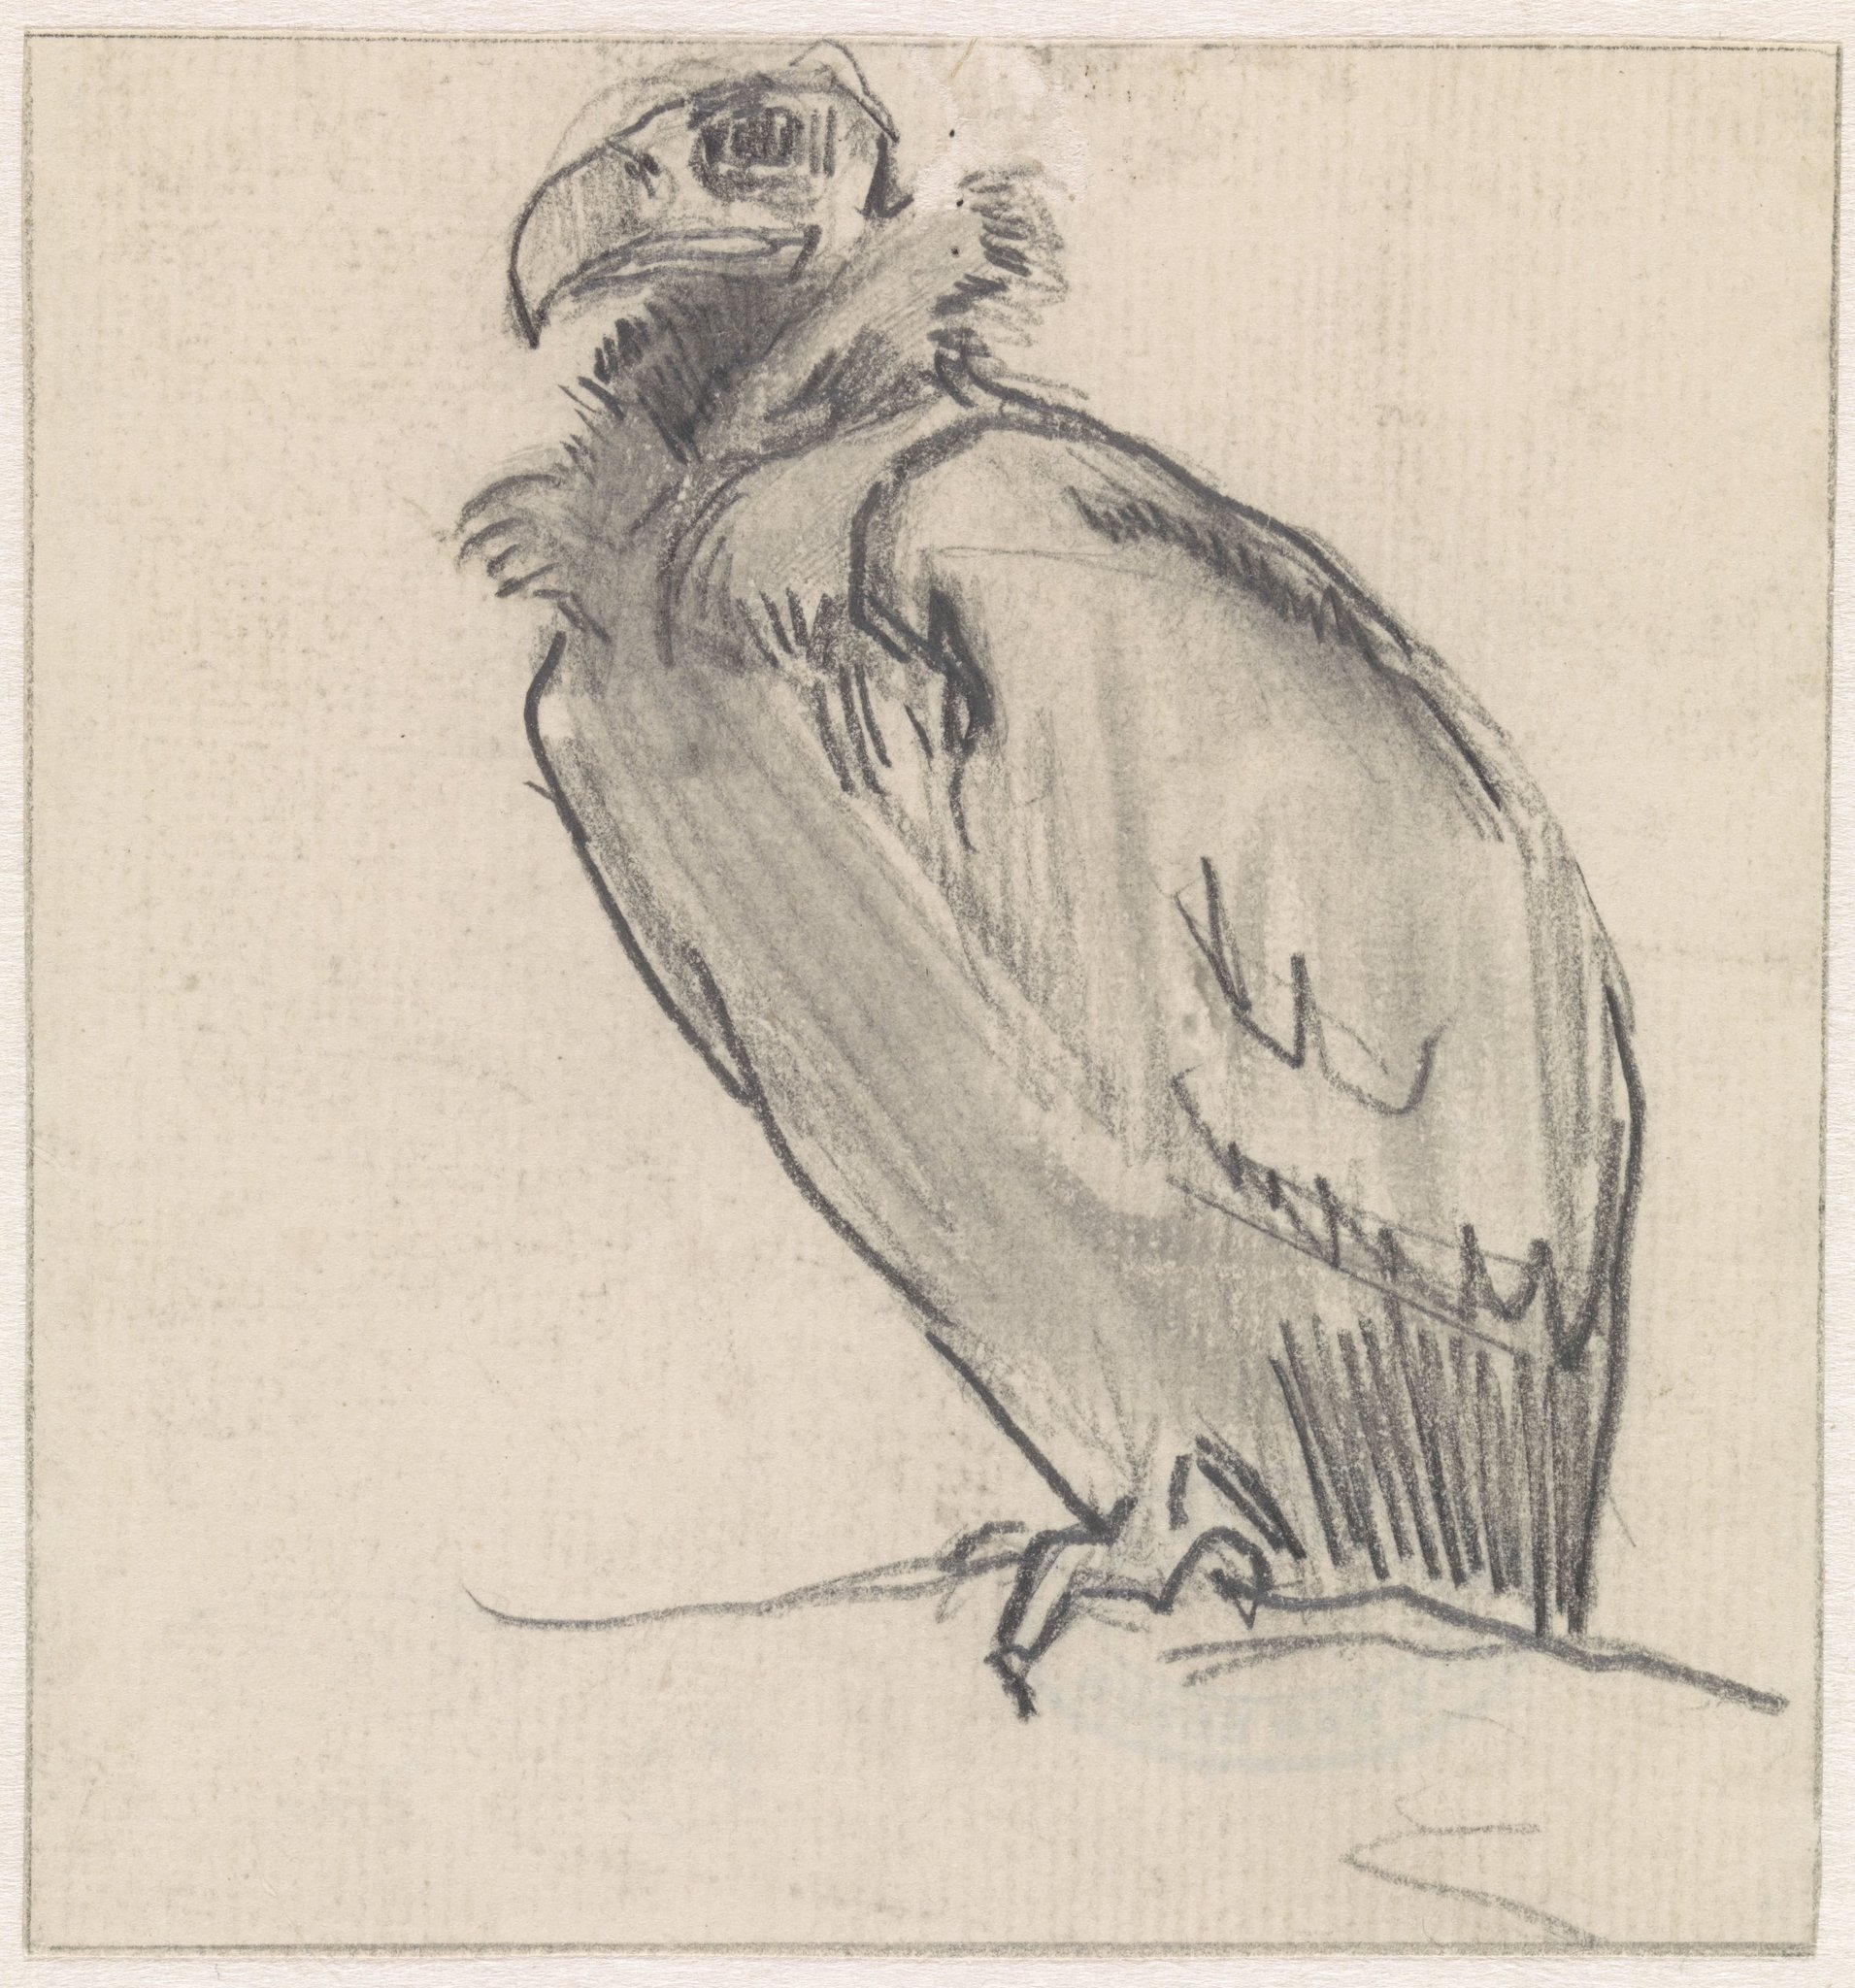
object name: drawing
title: Zittende gier, naar links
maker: jan van essen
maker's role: draughtsman, print maker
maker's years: 1854-1936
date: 1864-1936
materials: paper, pencil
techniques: brush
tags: predatory birds: vulture